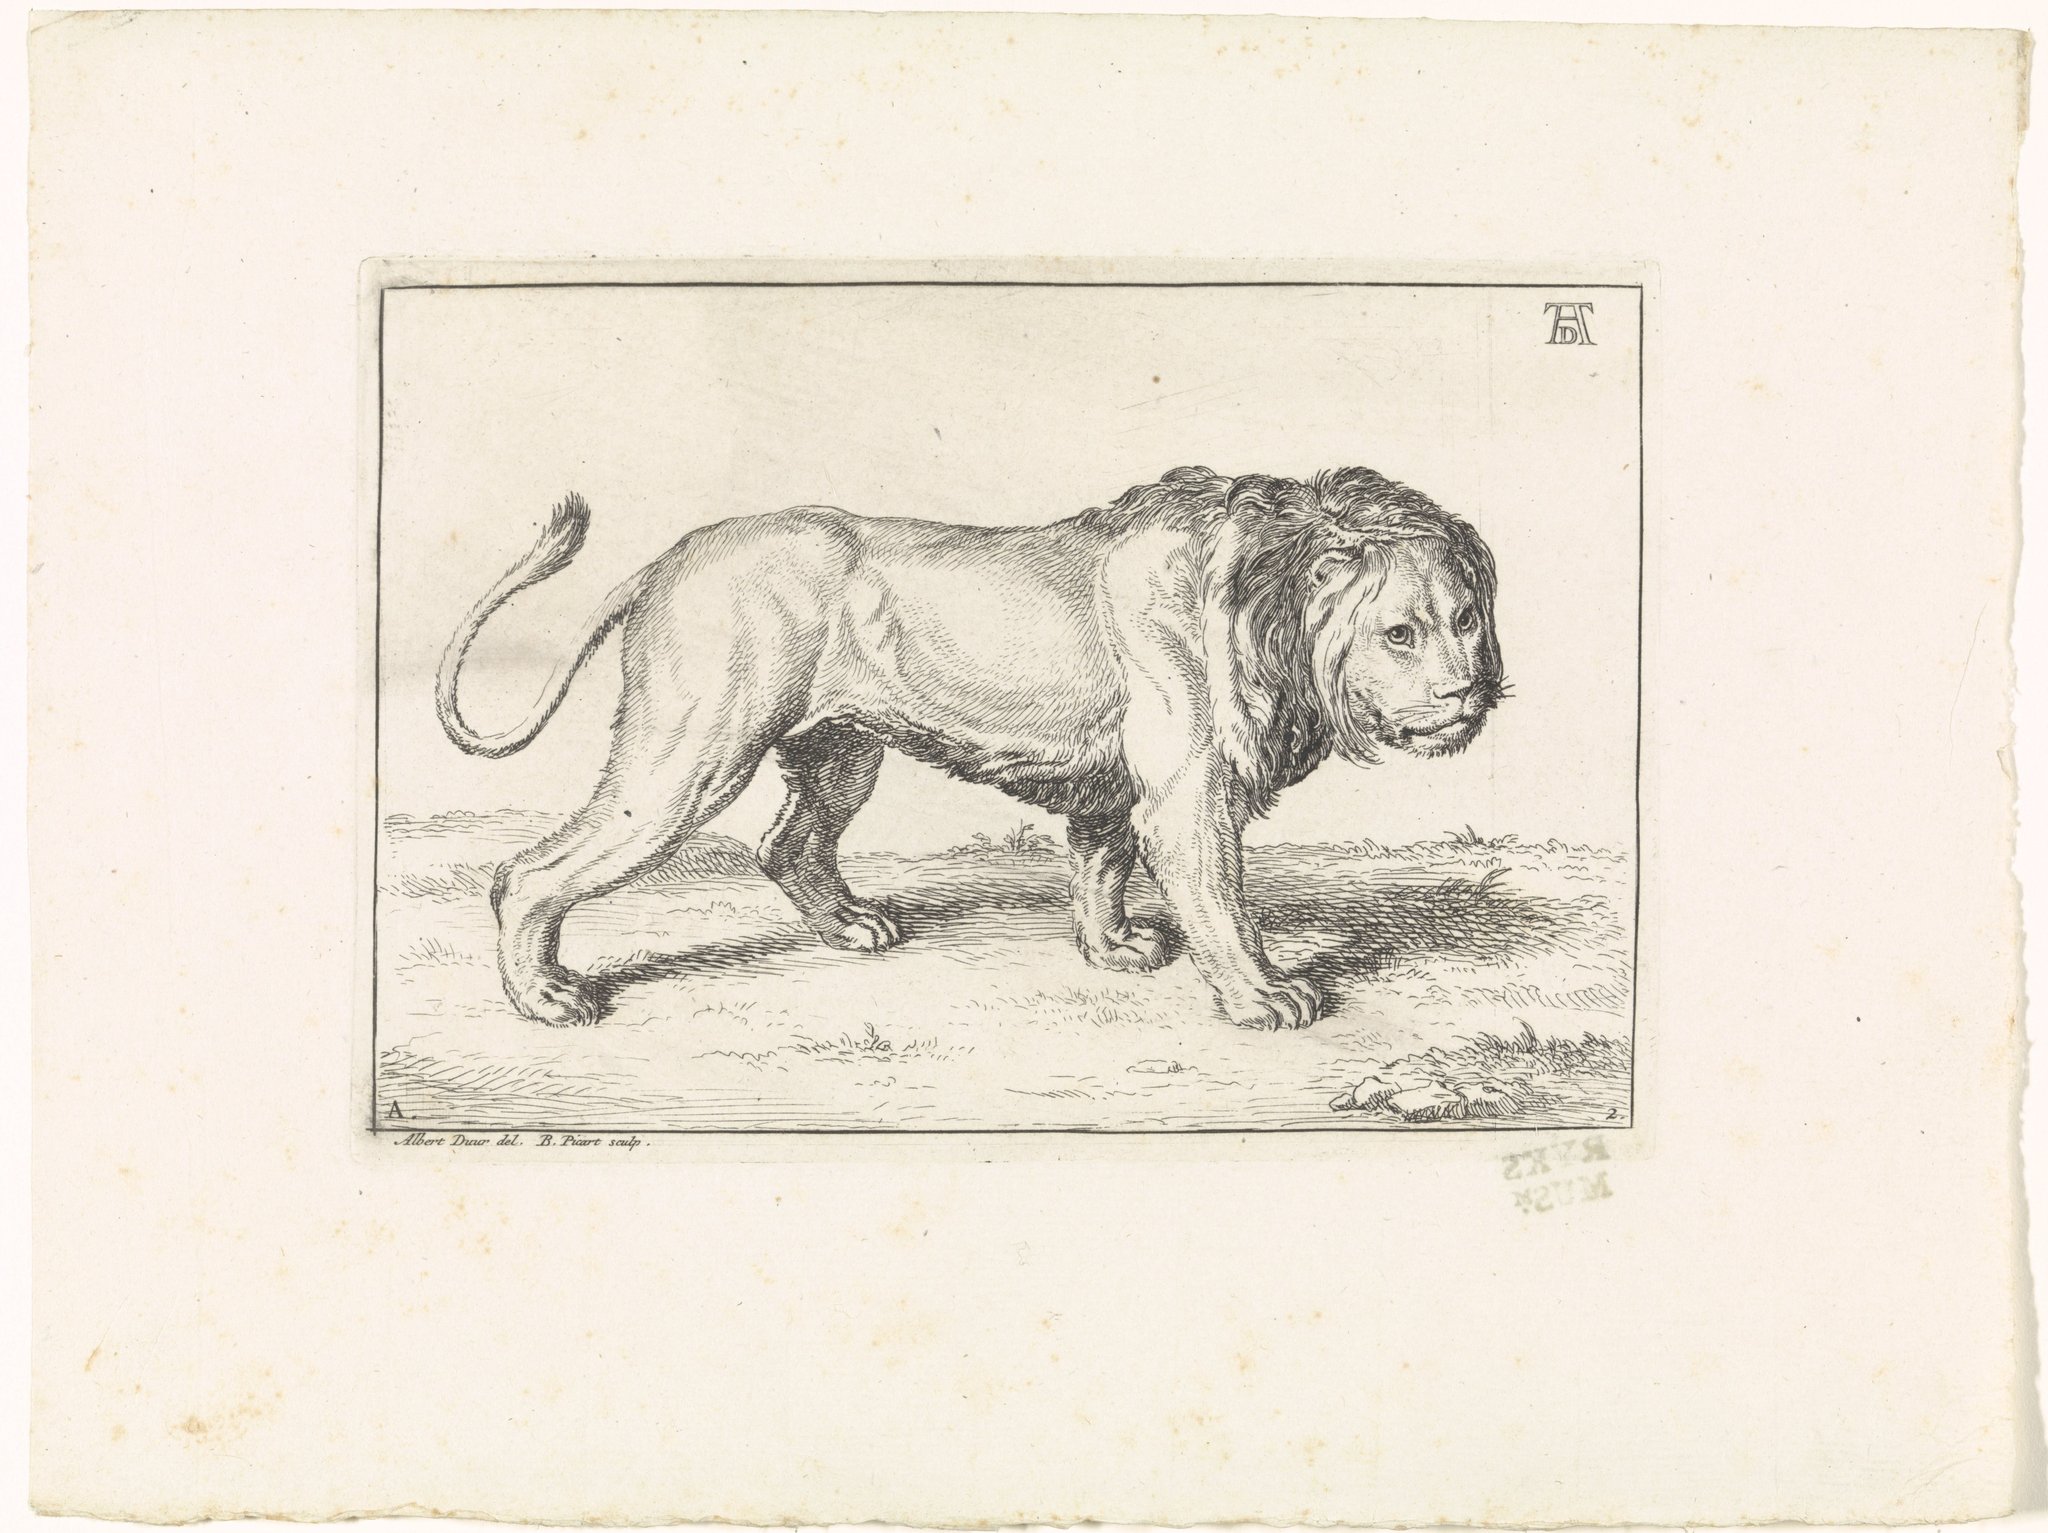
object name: book illustration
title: Landschap met leeuw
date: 1729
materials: paper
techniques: etching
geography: amsterdam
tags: beasts of prey, predatory animals: lion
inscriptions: collector's mark: Lugt 2165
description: Landschap met een leeuw die naar rechts loopt. Rechtsboven het monogram van Albrecht Dürer. Gemerkt linksonder: A. Genummerd rechtsonder: 2.